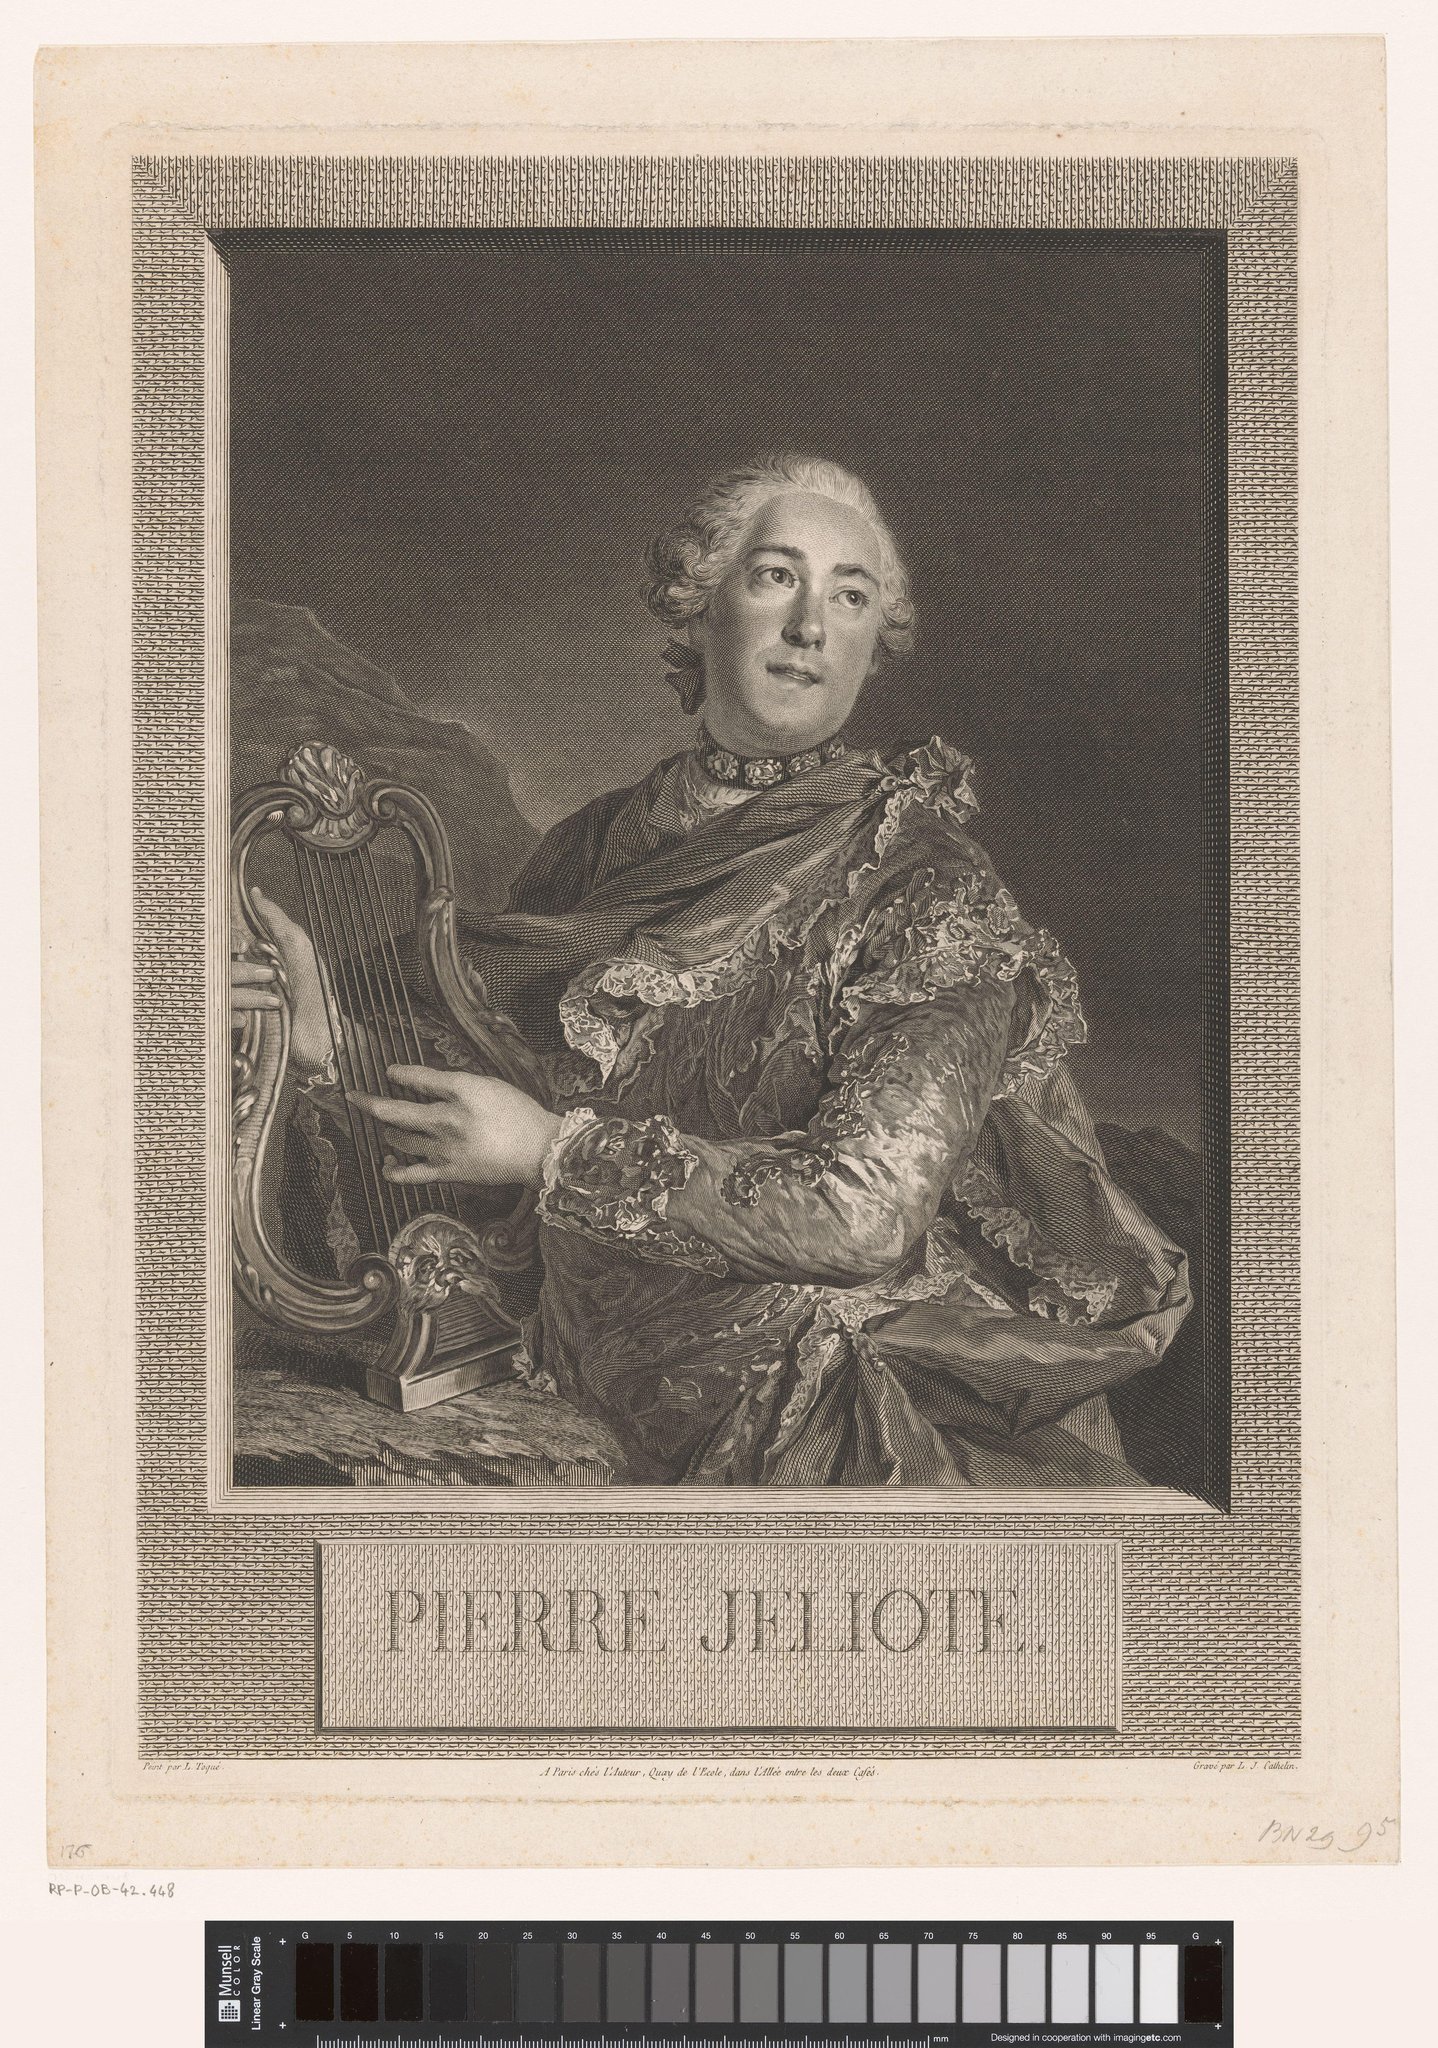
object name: print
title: Portret van Pierre de Jélyotte met een lier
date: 1769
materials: paper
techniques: engraving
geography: france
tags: lyre, cithara, psaltery, historical persons, portrait of composer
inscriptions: collector's mark: Lugt 2228